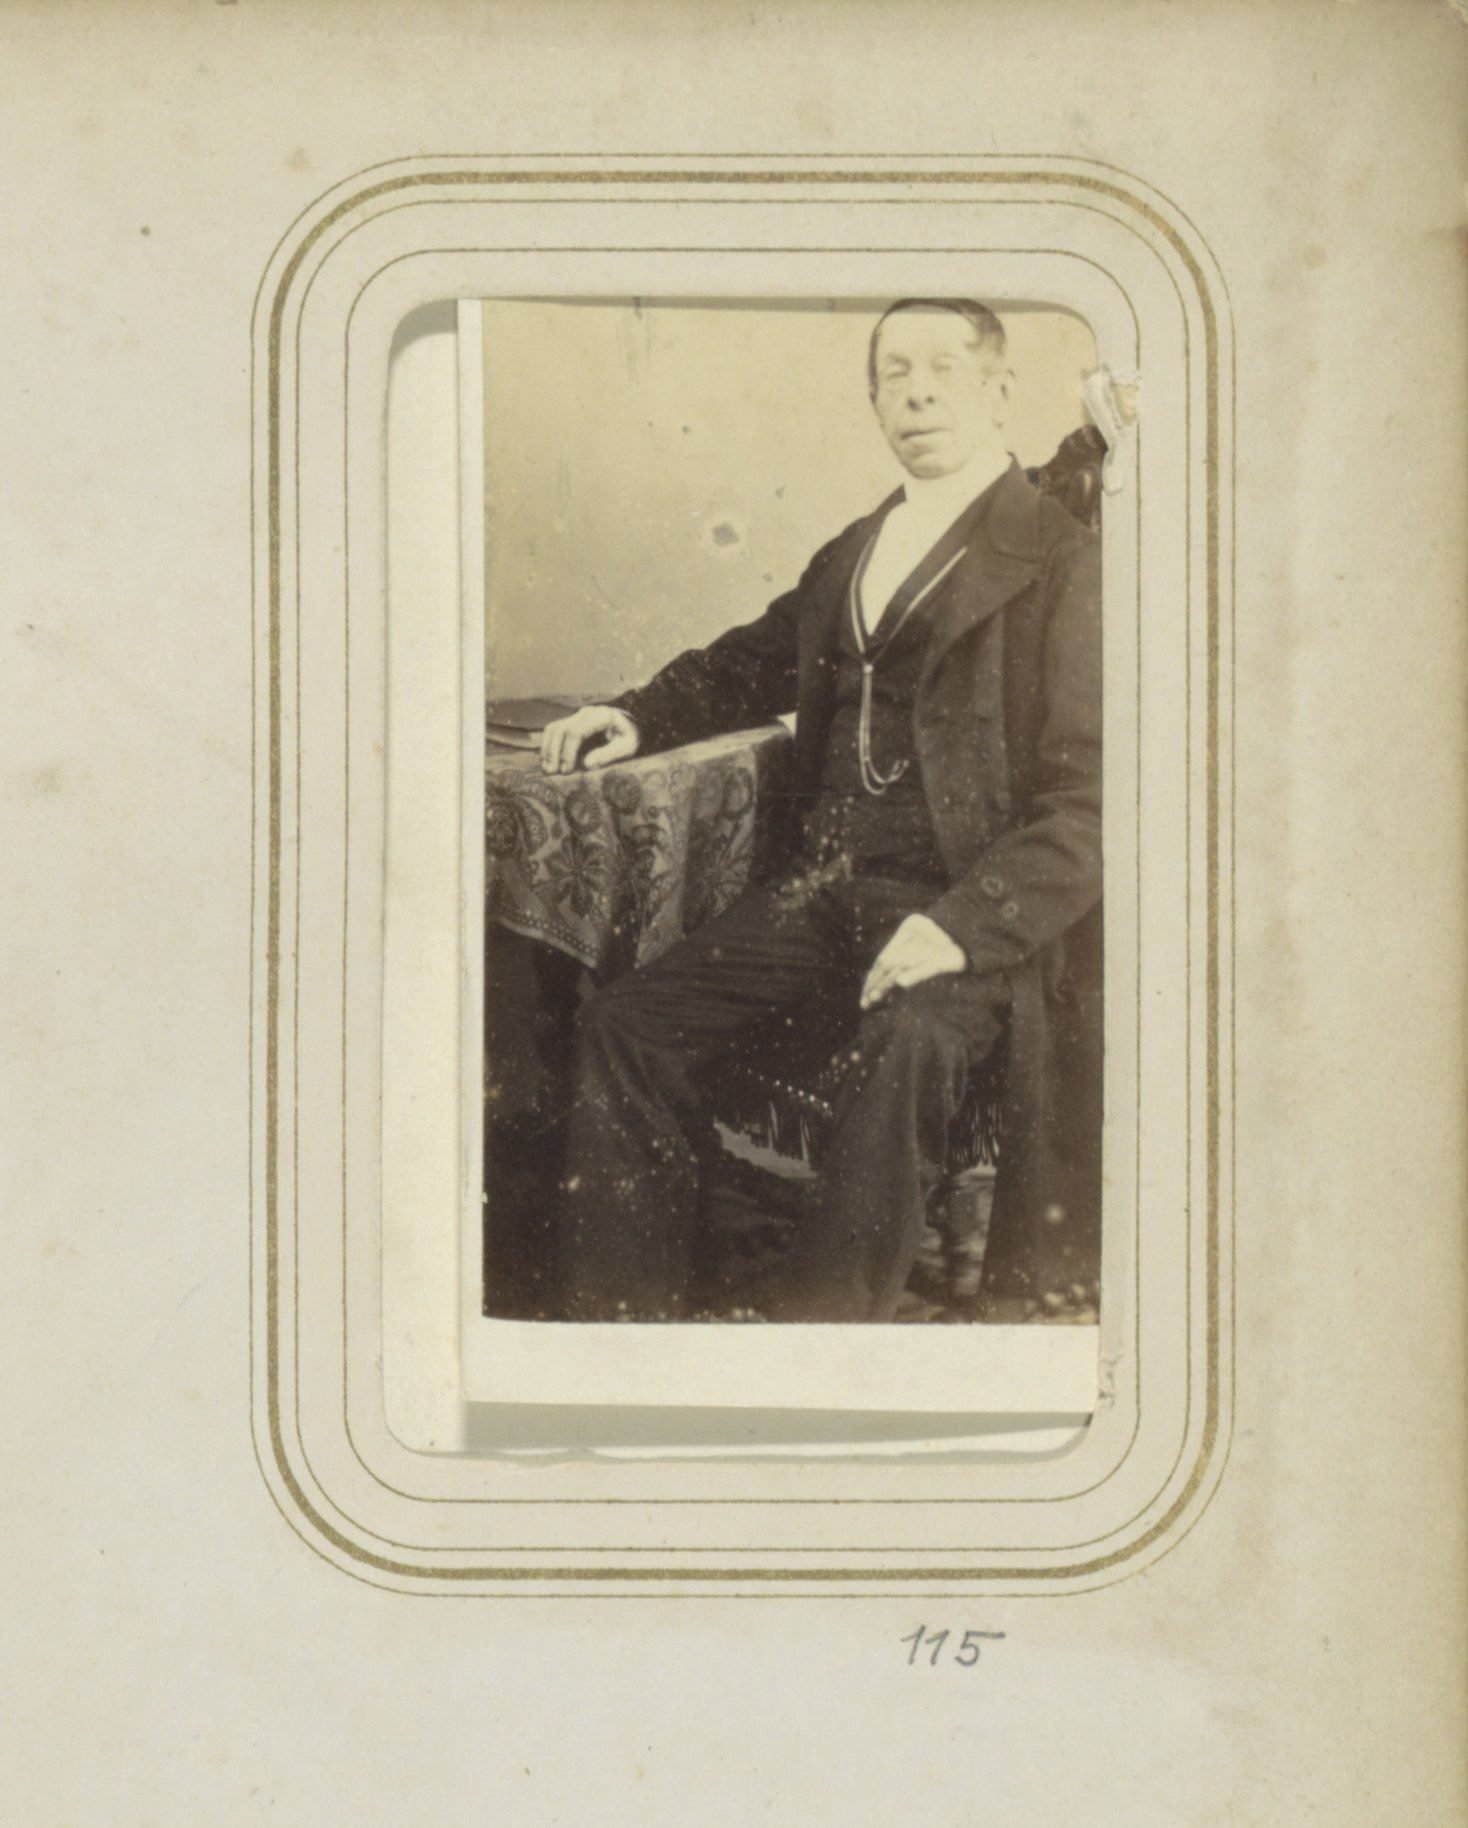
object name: carte de visite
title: Portret van een man in een lange jas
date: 1855-1880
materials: cardboard, photographic support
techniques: albumen print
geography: the hague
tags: studio requisites ~ photographer, trousers, breeches, historical persons, clothing for the upper part of the body, family, relationship, descent, book, hairdress, necklace, watch, coat, cape, the hague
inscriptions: address: ‘2 Wagenstraat No. 129 'S Hage.’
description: Onderdeel van Familiealbum van H.W.F. Ligtenberg en L.M. Swart met 149 foto's en cartes-de-visite.